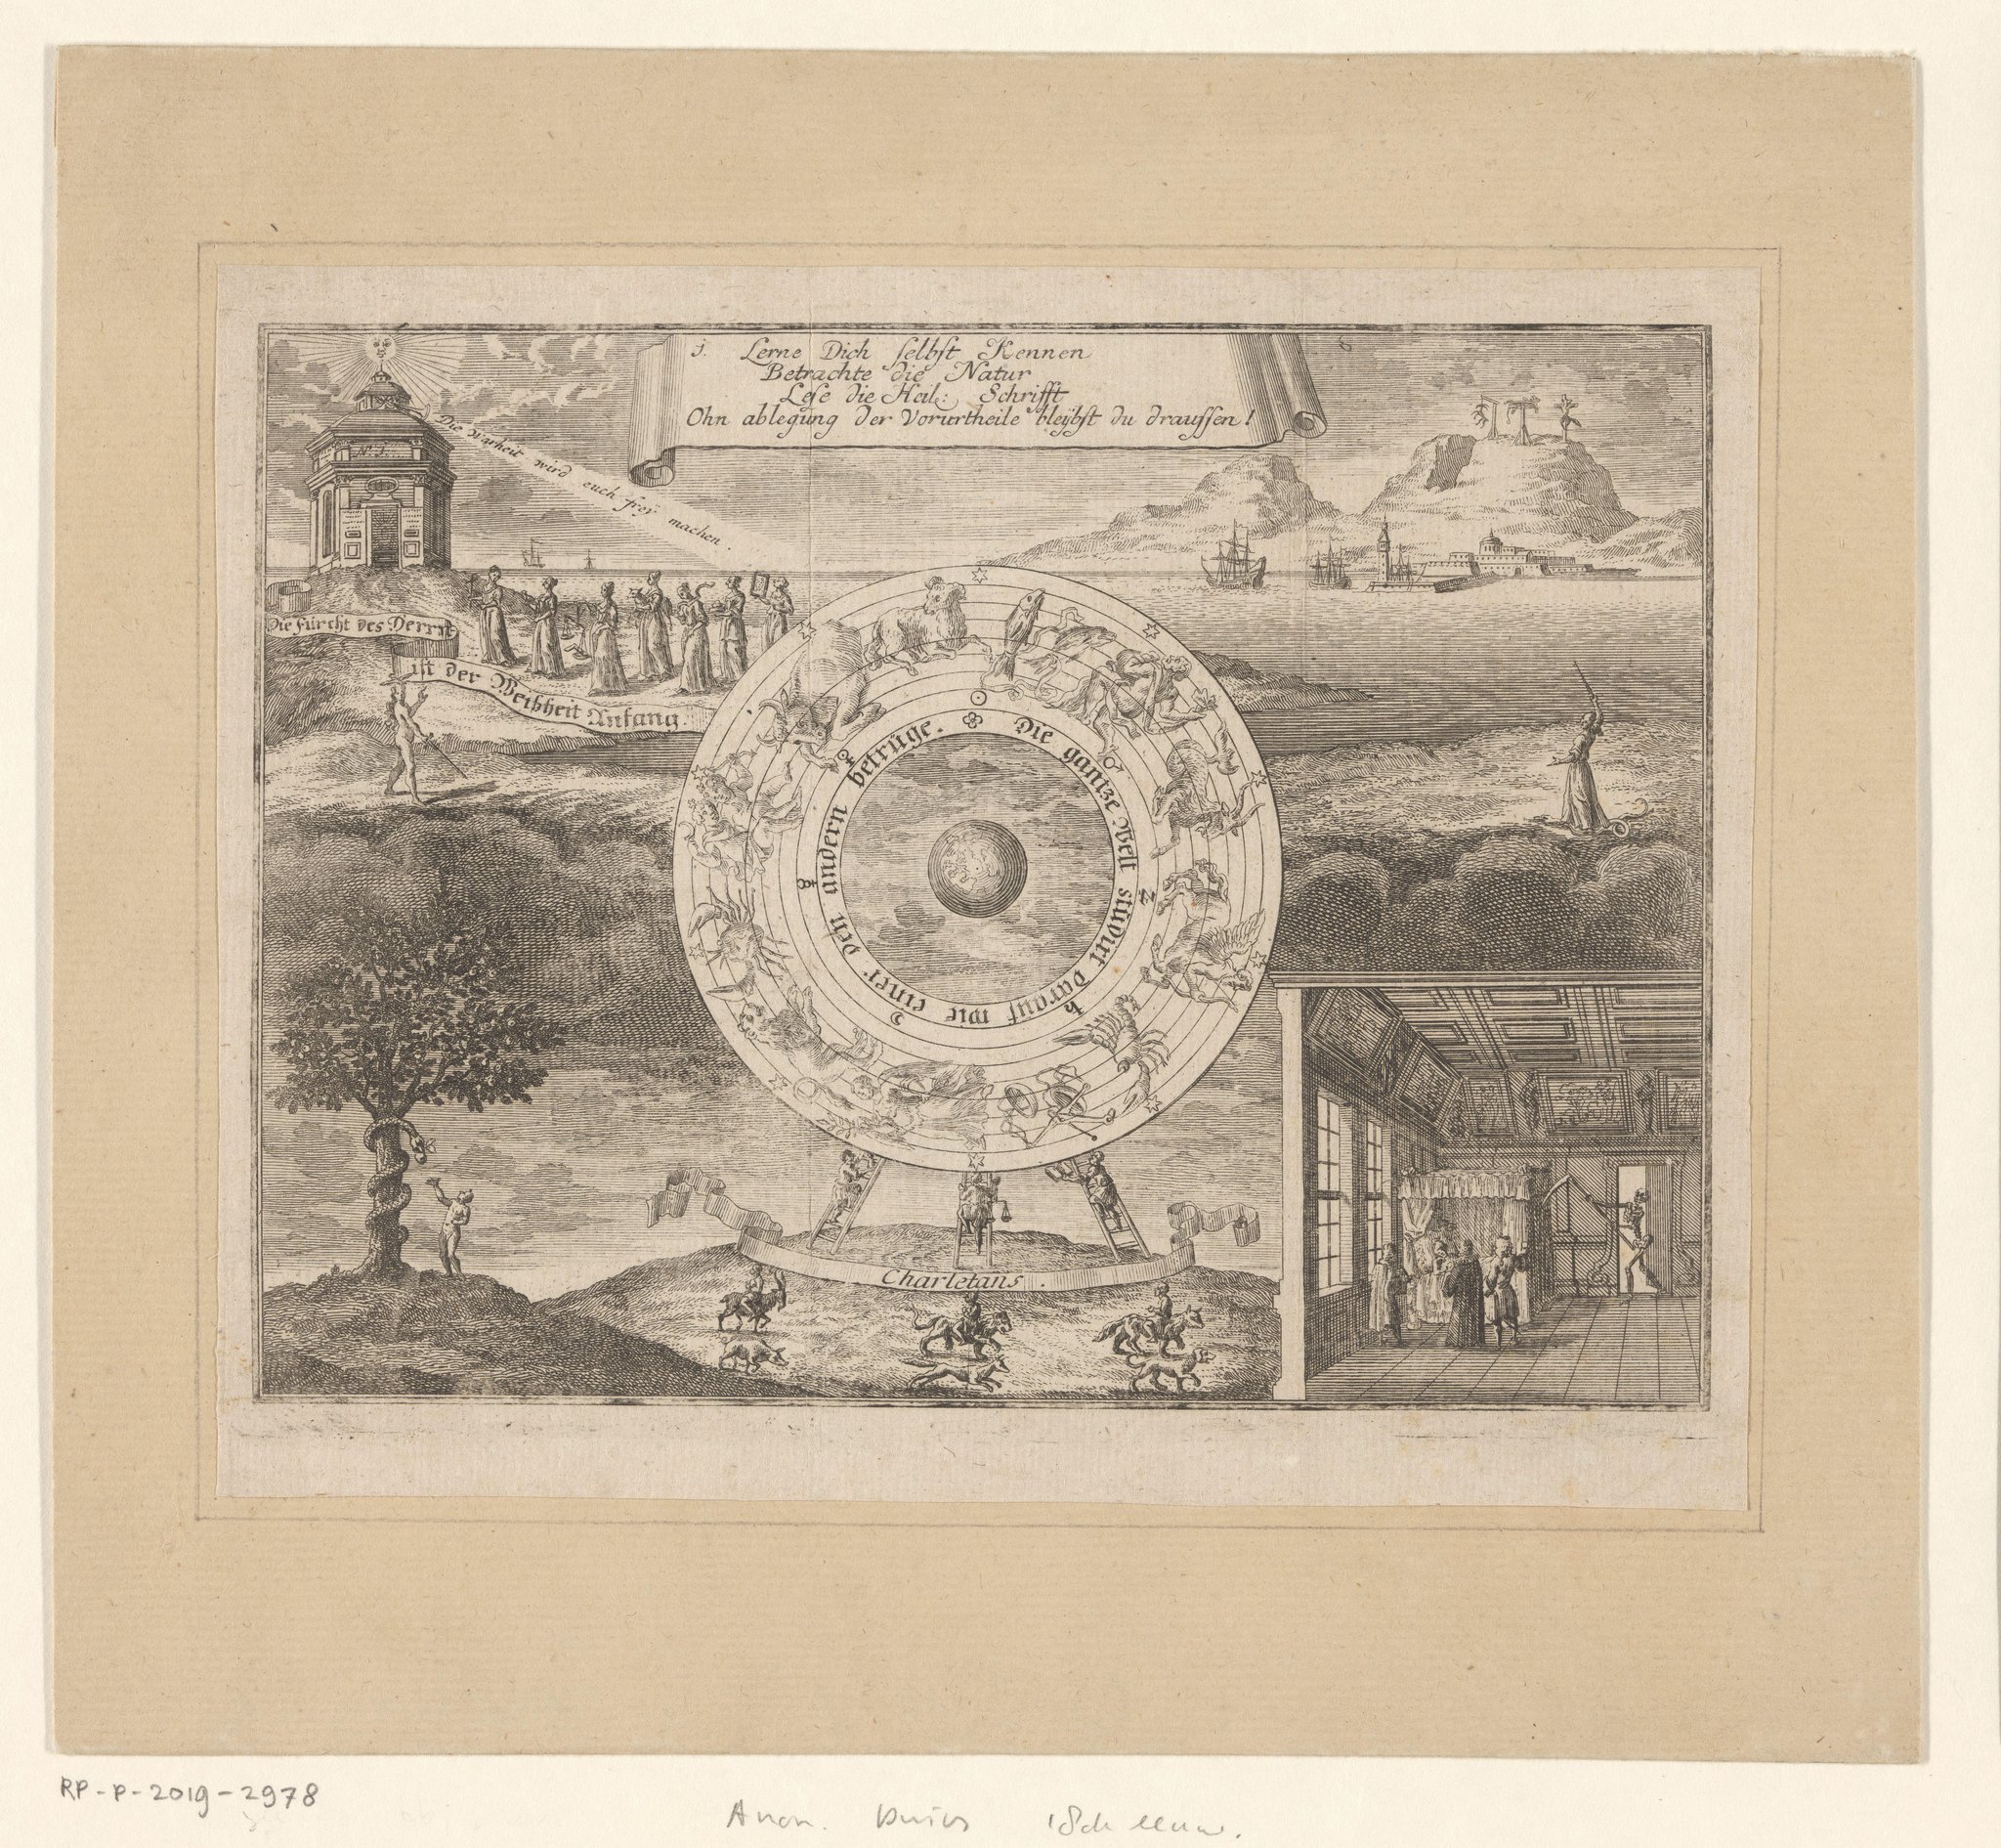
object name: print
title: Dierenriem omringd door Bijbelse scènes en een figuur op zijn sterfbed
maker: Anonymous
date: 1700-1799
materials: paper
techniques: etching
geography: germany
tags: eve takes the fruit, deathbed, zodiac; the twelve zodiacal signs together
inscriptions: collector's mark: Lugt 2228